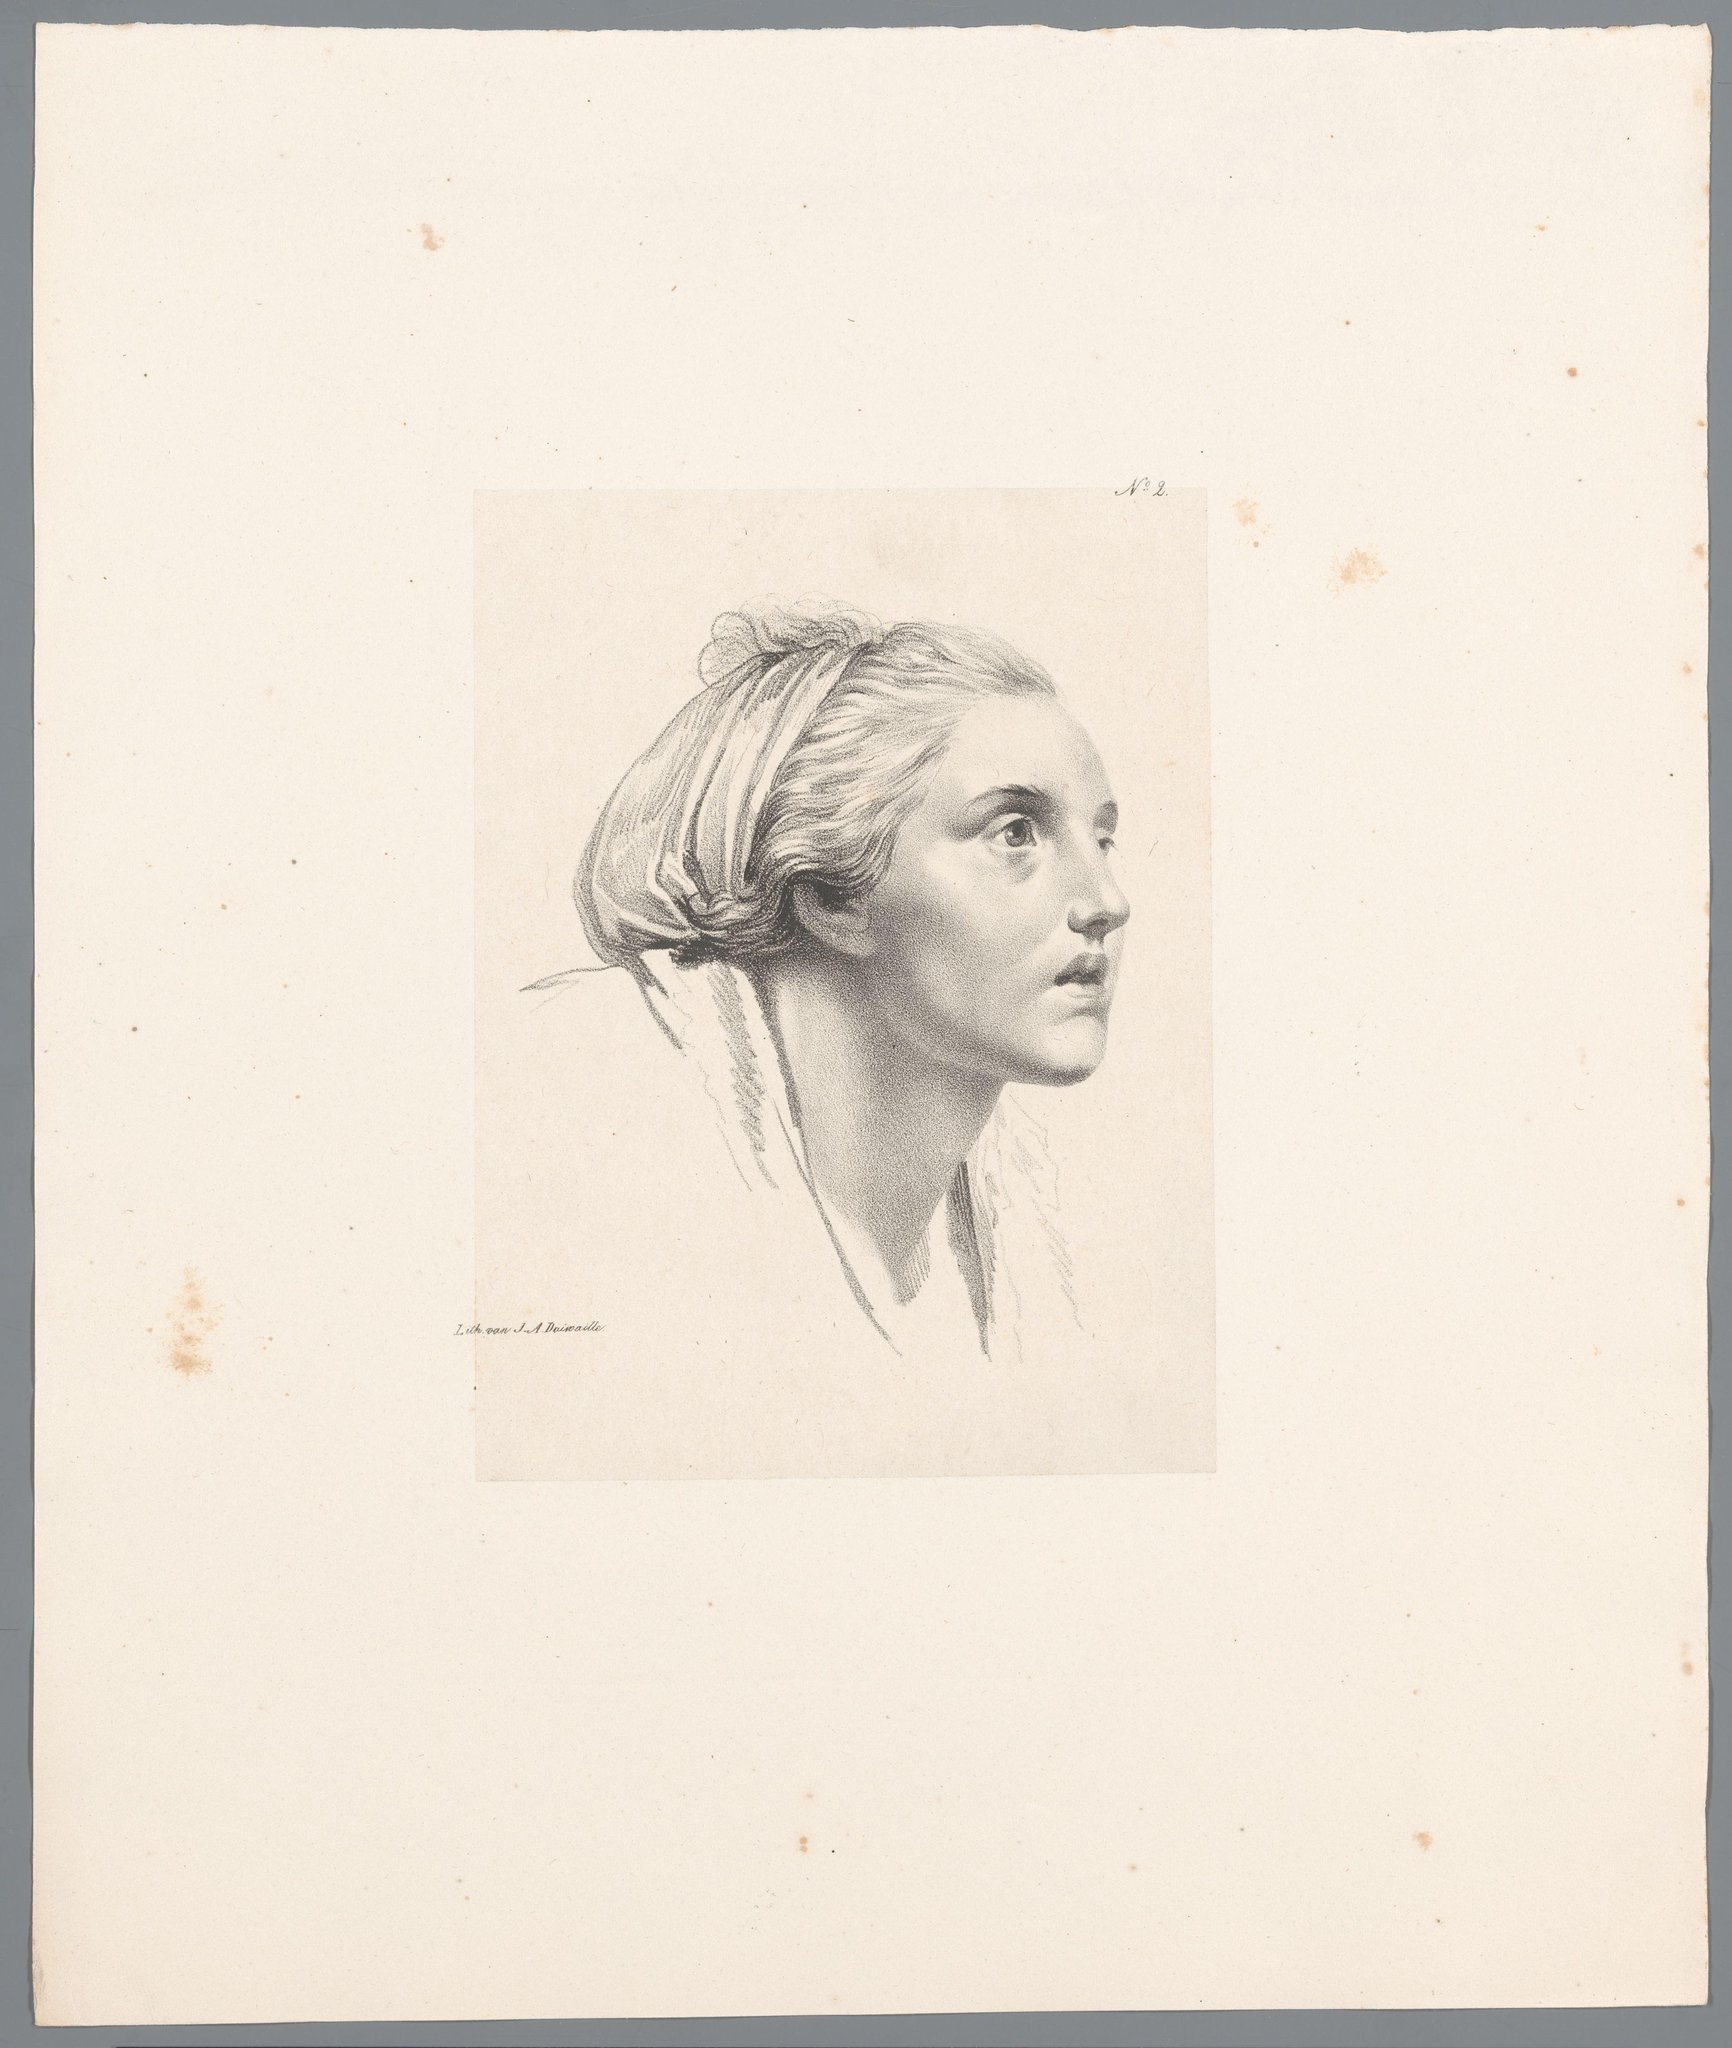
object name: print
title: Hartstochten na J.B. Greuze Nummer Twee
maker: jean augustin daiwaille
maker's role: draughtsman, print maker, printer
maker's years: 1786-1850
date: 1820-1830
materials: paper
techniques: lithograph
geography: amsterdam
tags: head-gear (with name), adolescent, young woman, maiden (+ three-quarter view)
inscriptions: collector's mark: Lugt 2228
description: 'Hartstochten na J.B. Greuze' bestaat uit twee of drie genummerde reeksen. (Sommige nummers komen drie keer voor op drie verschillende afbeeldingen.) Binnen deze omslag bevinden zich achttien verschillende afbeeldingen. Mogelijk heeft dit te maken met de twee momenten waarop Daiwaille de reeks uitgaf, ten tijden van zijn directeurschap aan de Rijksakademie in Amsterdam en daarna als zelfstandige. De omslag behoort waarschijnlijk bij een van deze twee series. Zie Marres-Schretlen in het Bulletin van het Rijksmuseum.